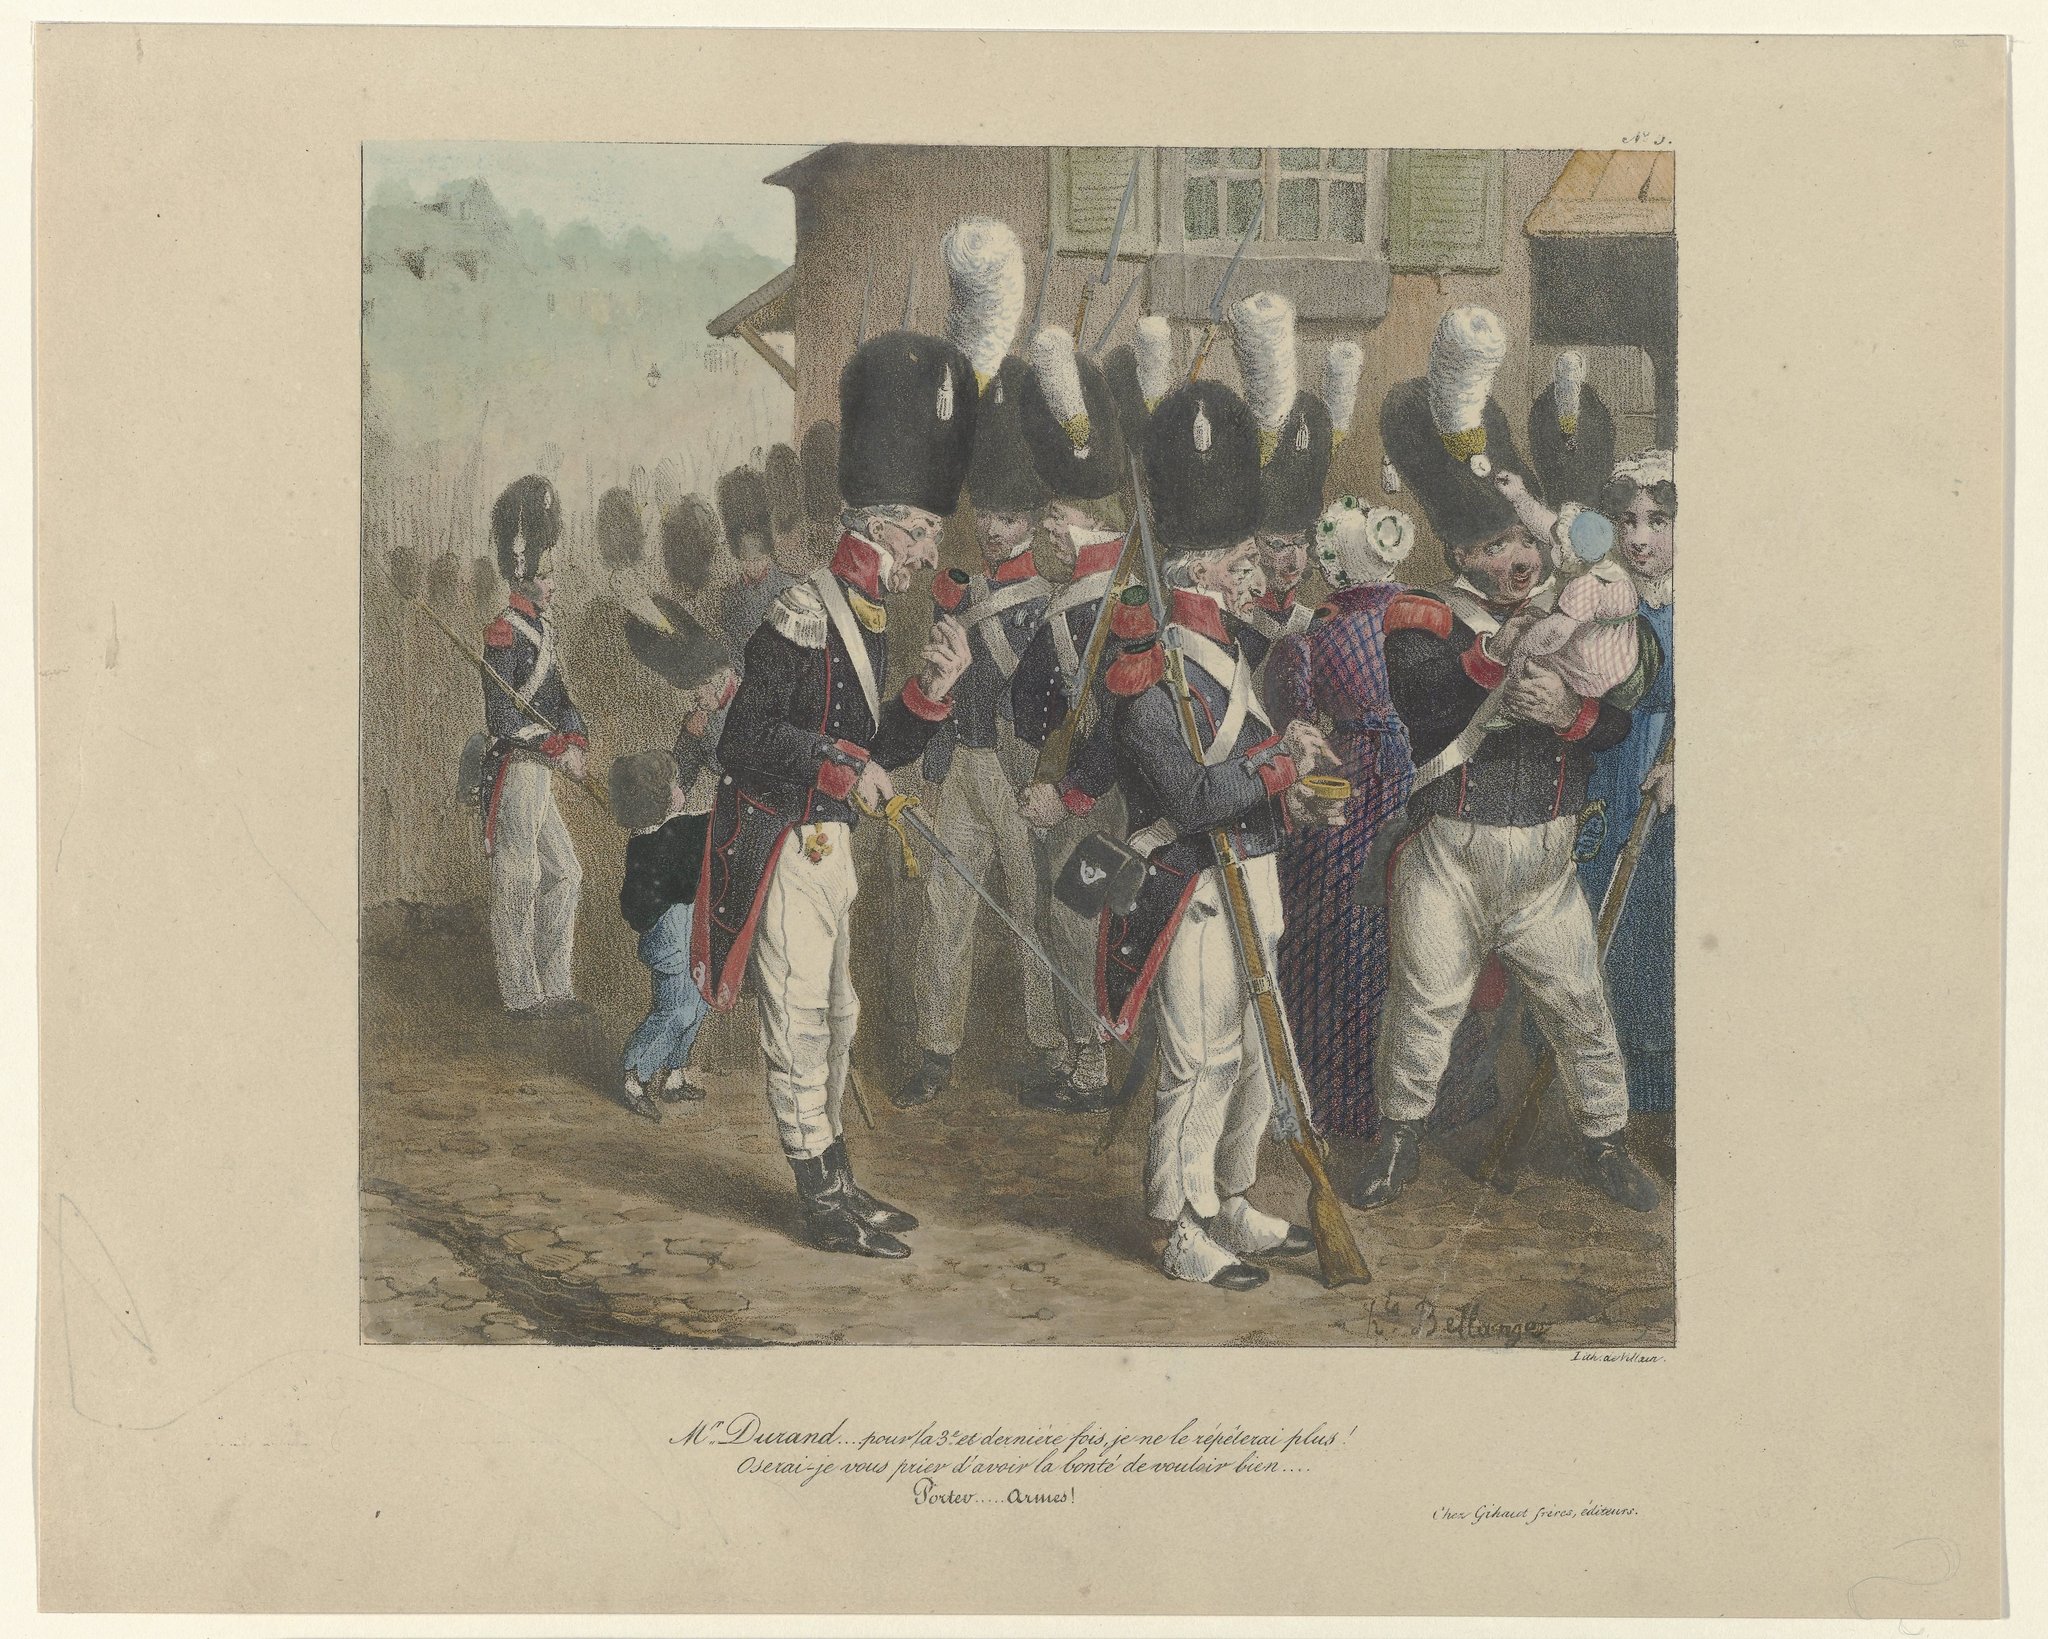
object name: print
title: Mr. Durand. pour la 3e et dernière fois (...)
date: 1810-1866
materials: paper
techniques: hand coloring, lithograph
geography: paris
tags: (military) uniforms, military clothing and other equipment (uniforms, cap, armour, helmet, etc.), father and child(ren), man and child(ren) (family group)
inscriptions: caption: ‘Mr. Durand, pour la 3e et dernière fois, je ne le répêterai plus! Oserai-je vous prier d'avoir la bonté de vouloir bien... / Porter...Armes!’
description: Een groep soldaten voor een woonhuis, waar vrouwen en kinderen hen groeten.